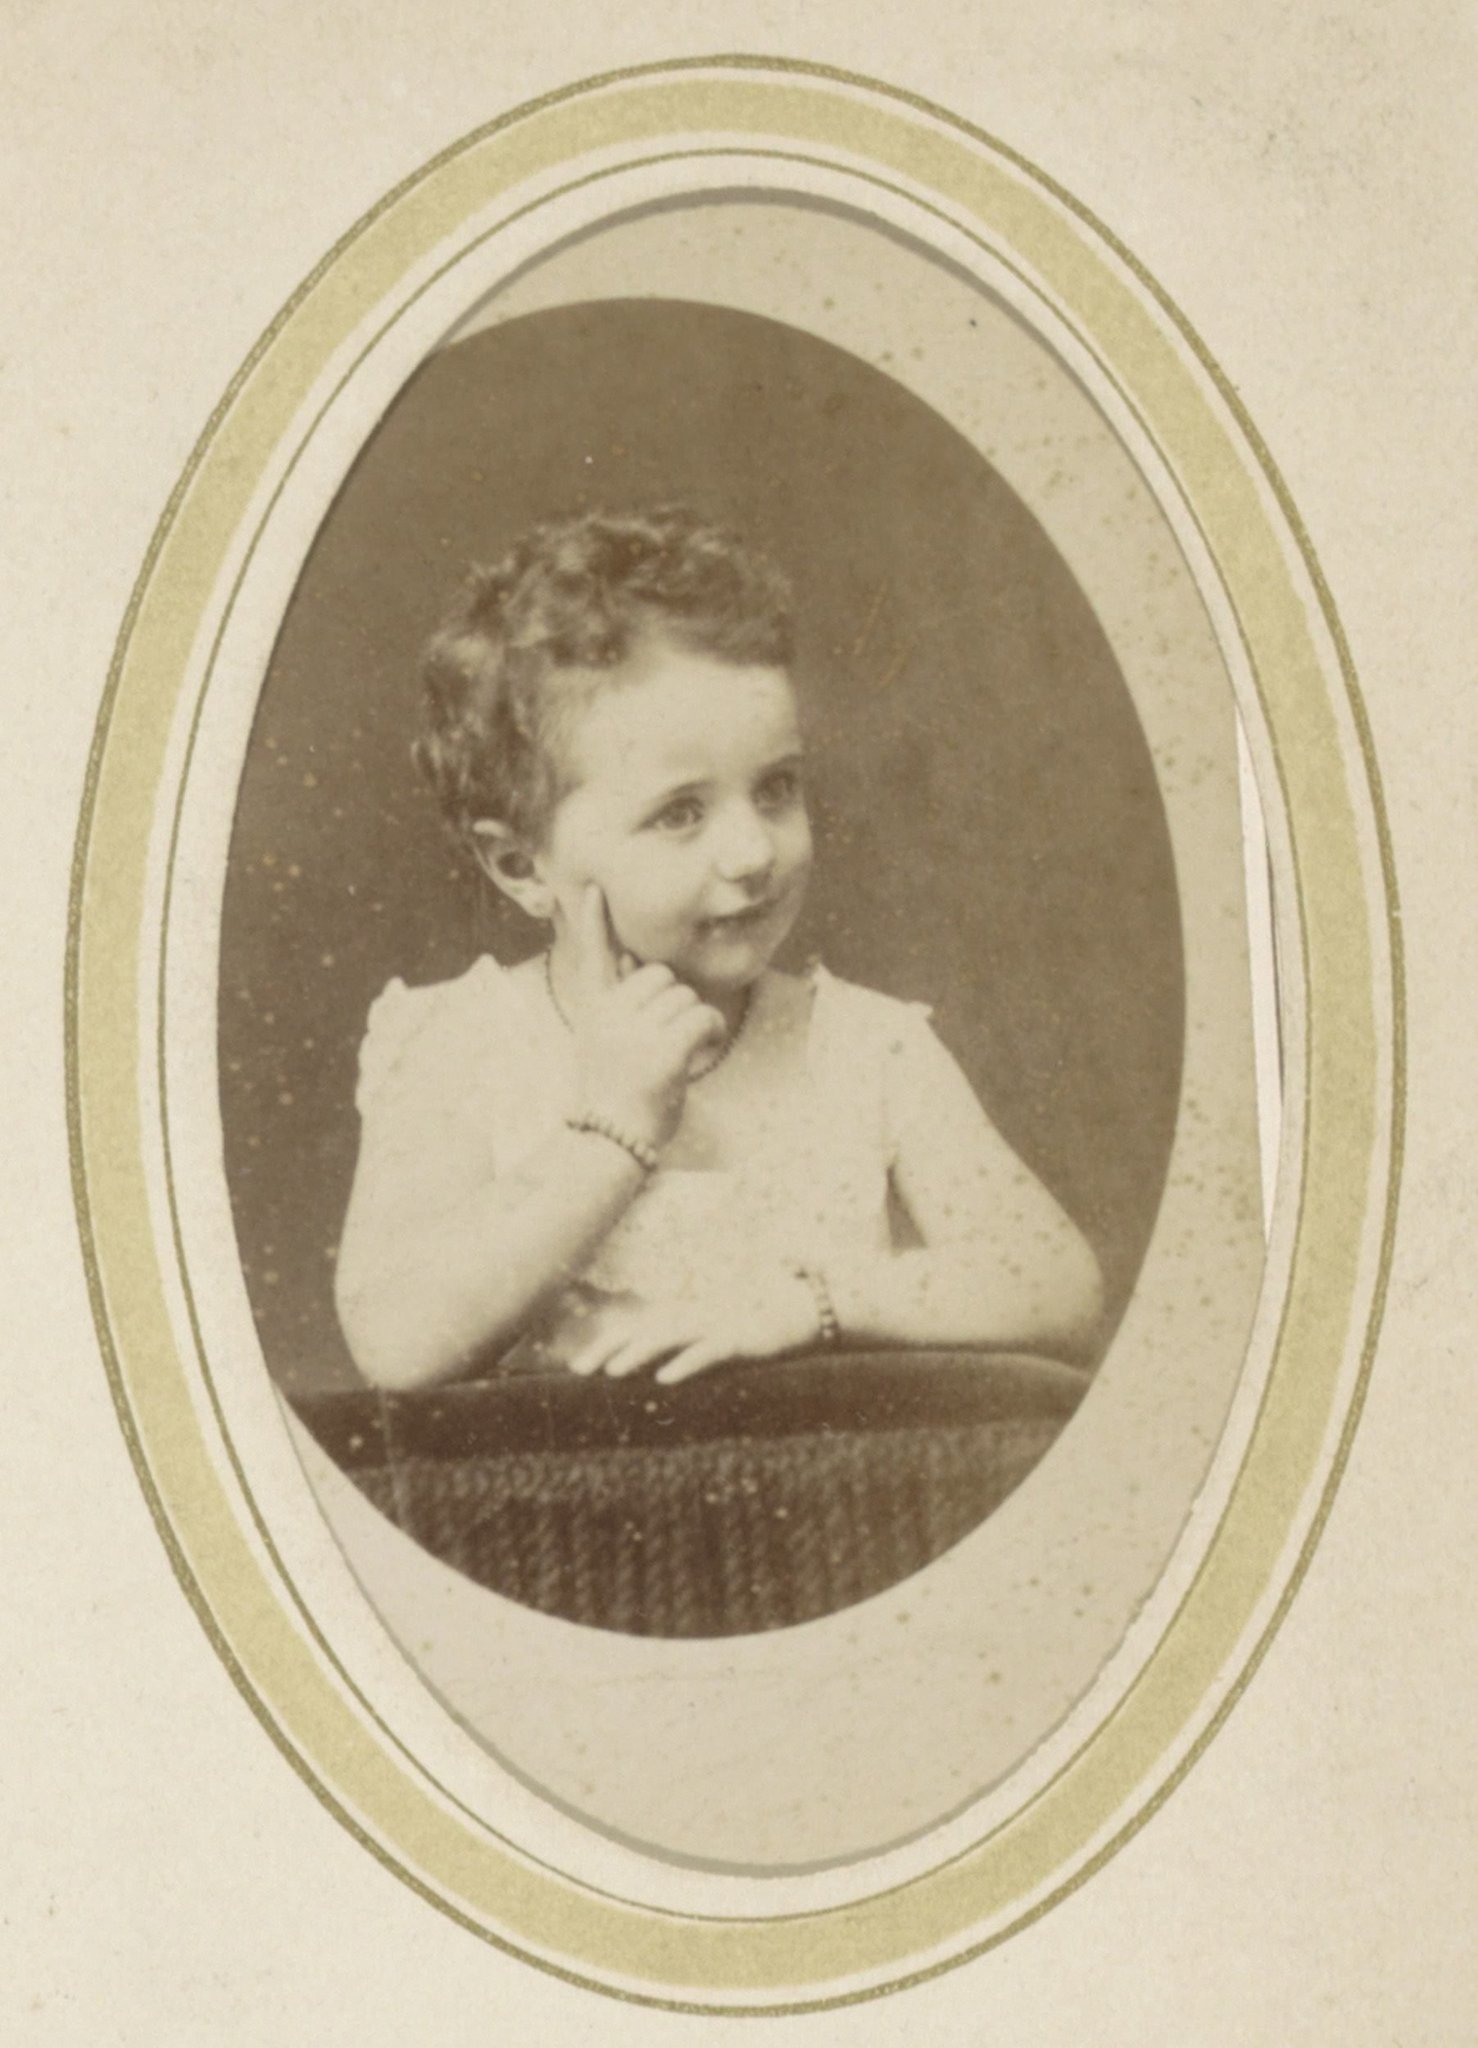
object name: photograph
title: Portret van een jong kind met twee armbanden, een vinger tegen de wang houdend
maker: h. bulens jr.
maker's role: fotograaf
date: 1860-1900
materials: cardboard, paper, photographic support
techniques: albumen print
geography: winterswijk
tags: studio requisites ~ photographer, child, historical persons, styles of hairdress - aa - ~ women, bracelet, wristlet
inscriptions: address: ‘Winterswijk’, address: ‘Spoorstraat Winterswijk’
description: Onderdeel van Fotoalbum van een Nederlandse familie met 168 cartes-de-visite en kabinetfoto's.